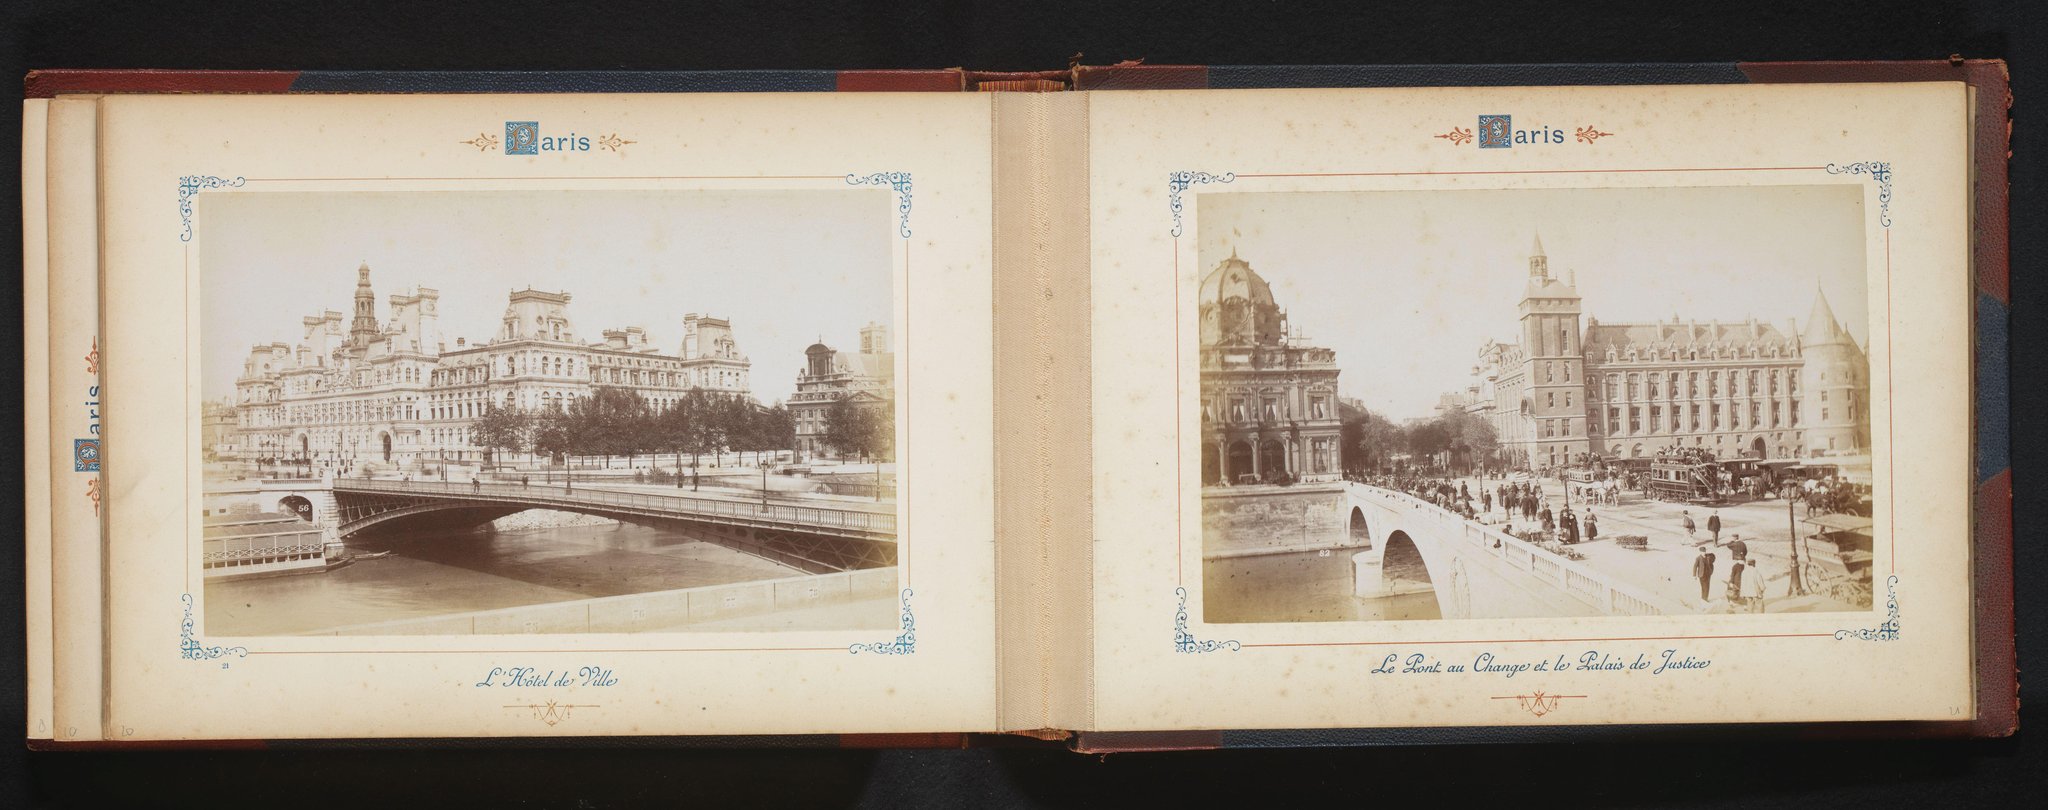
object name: photograph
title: Gezicht op het stadhuis van Parijs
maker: Anonymous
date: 1879-1889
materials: photographic support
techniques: albumen print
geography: paris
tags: townhall, façade (of house or building)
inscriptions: number: ‘56’